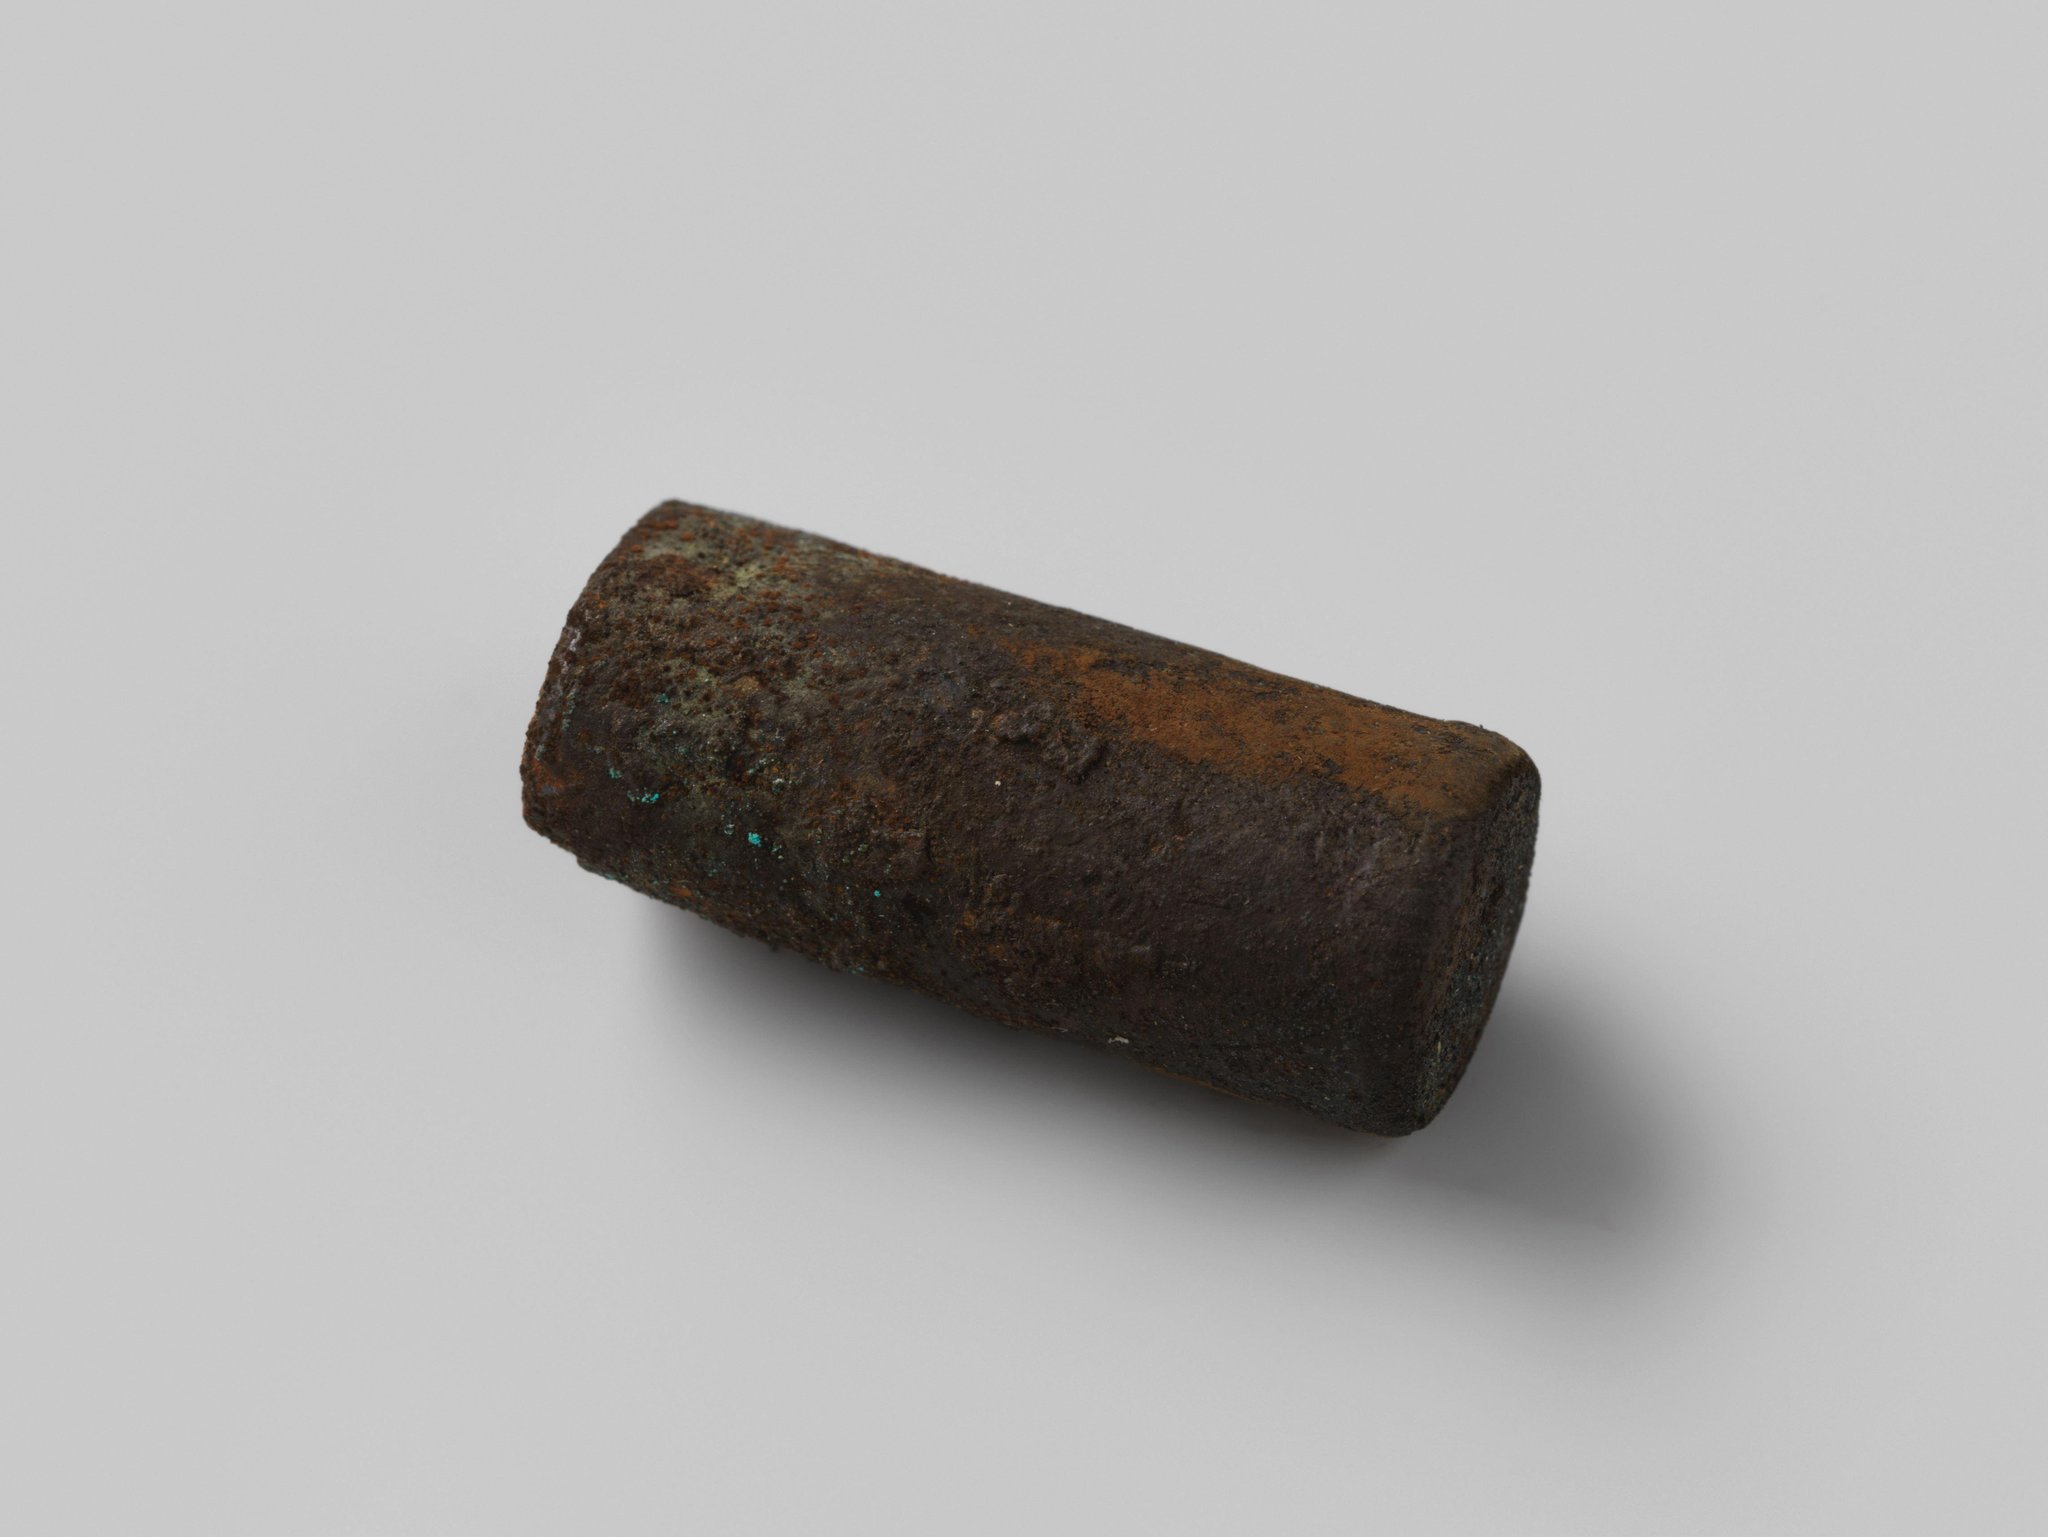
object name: cap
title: Dop uit het wrak van de Oost-Indiëvaarder Hollandia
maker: Anonymous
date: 1700-1743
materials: copper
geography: netherlands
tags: verenigde oostindische compagnie, hollandia (schip), annet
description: Varied parts or fragments, caps; cylindrical, flat top, internally threaded.